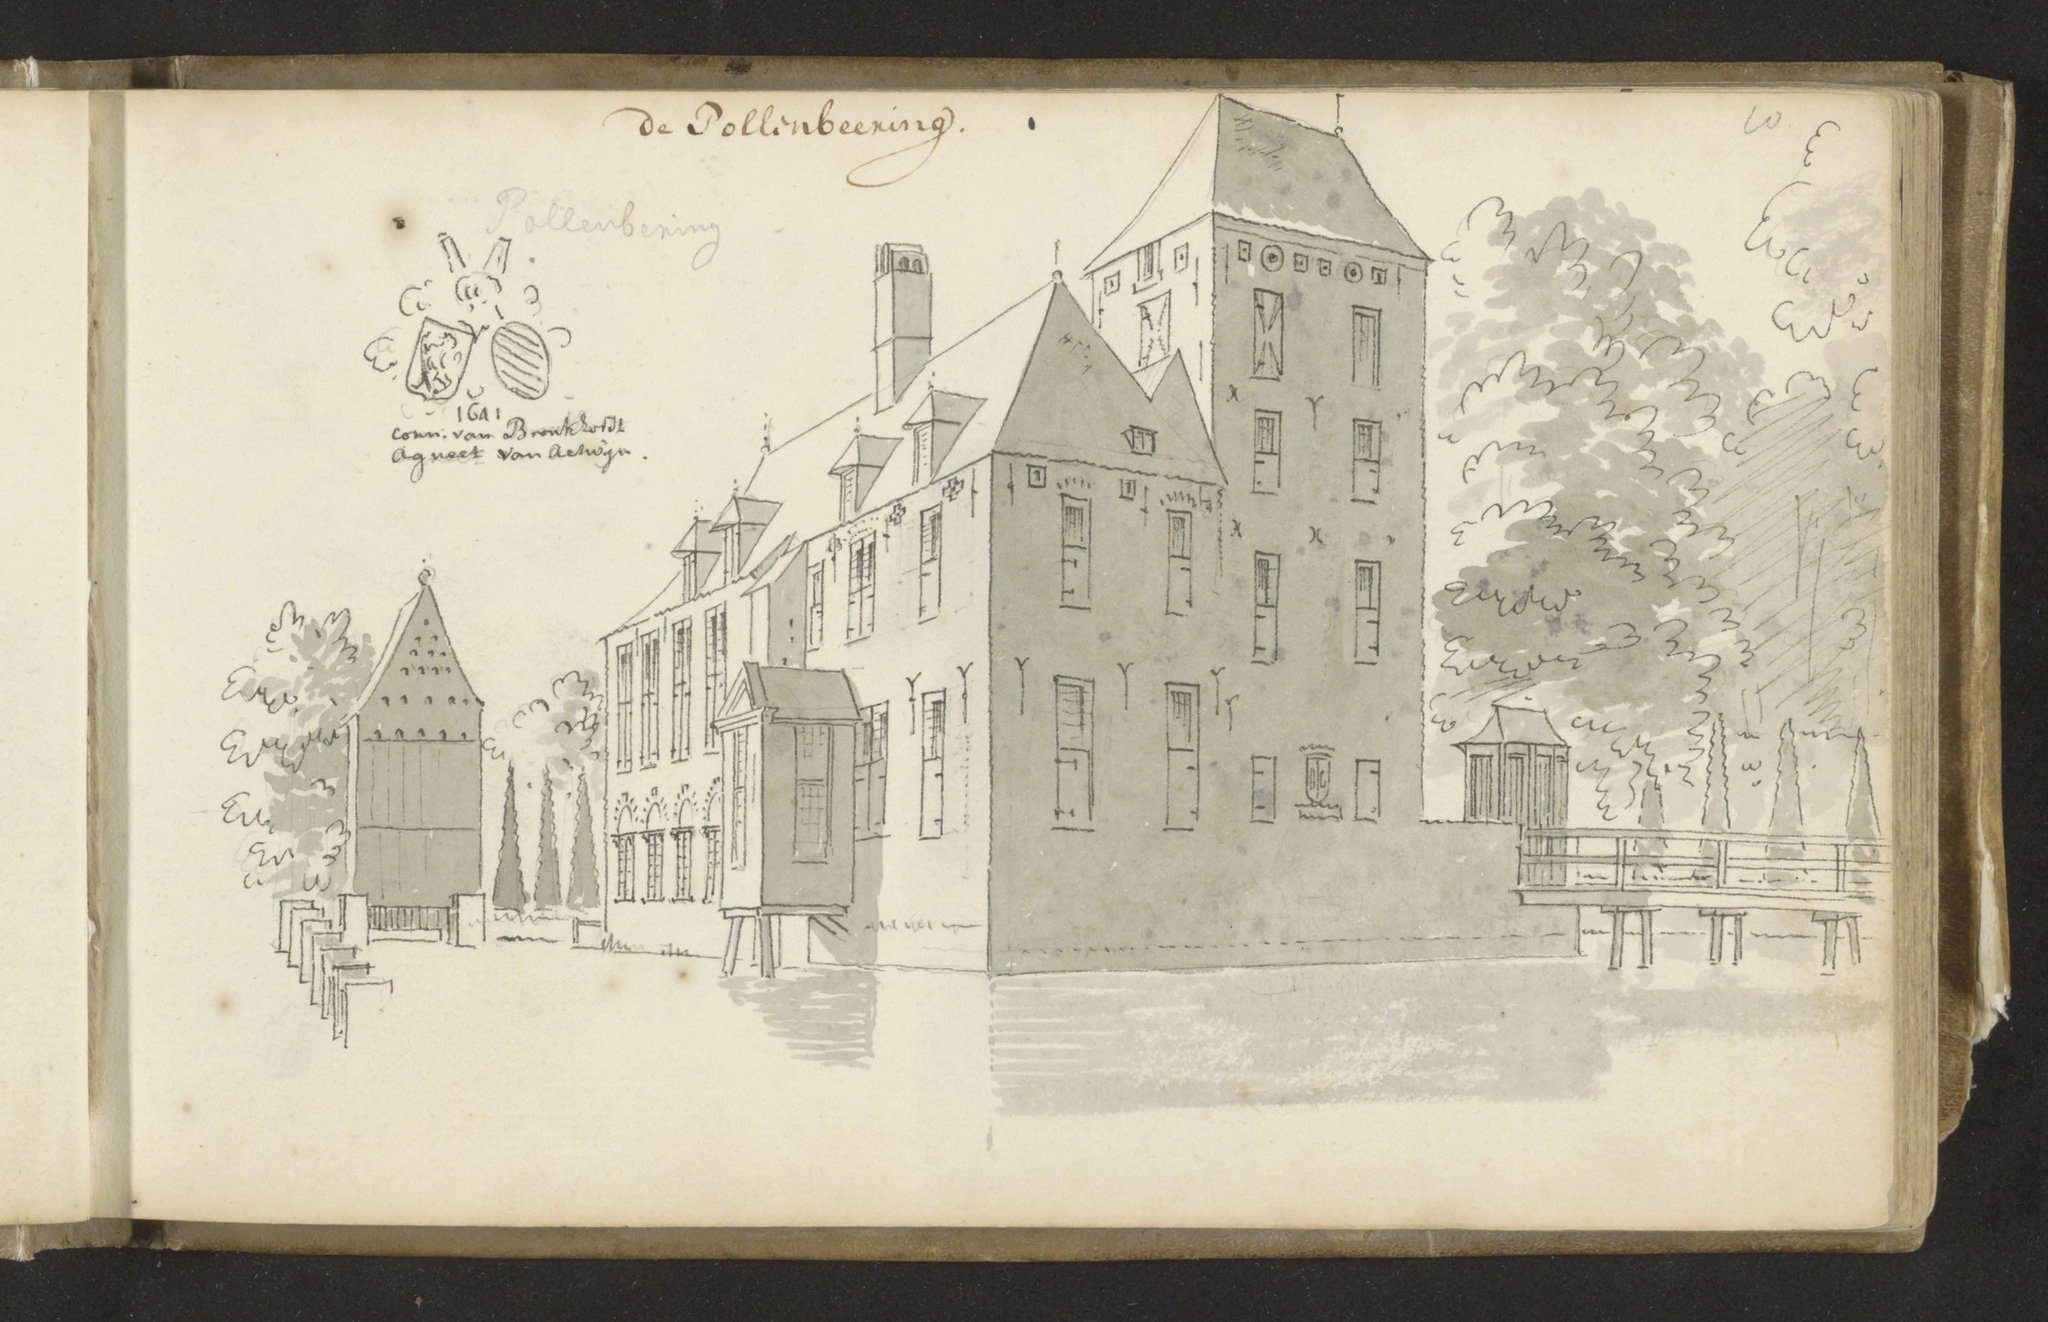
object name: sketchbook leaf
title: Huis De Pollenbering te Bemmel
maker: abraham de haen (ii)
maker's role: draughtsman, print maker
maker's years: 1707-1748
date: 1731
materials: ink, paper, pencil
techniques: brush, pen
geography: bemmel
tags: castle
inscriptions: annotation: ‘Pollenbering/ onder Bemmel/ vermoedelijk gesloopt’, annotation: ‘de Pollenbeering/ Pollenbering/ com. va Bronkhorst. Agneet va Aelwijn.’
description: Huis De Pollenbering te Bemmel gezien vanaf de zijkant en achterzijde met op voorgrond gracht. Linksboven schets van familiewapen. Blad 10 recto uit een schetsboek met 69 bladen.